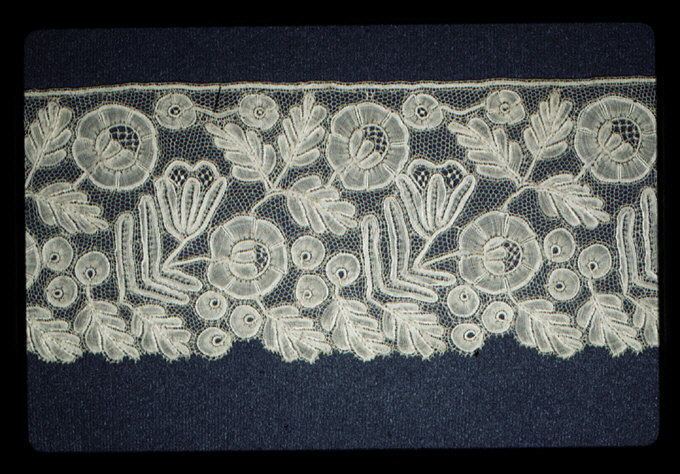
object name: strip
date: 1801-1900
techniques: lace